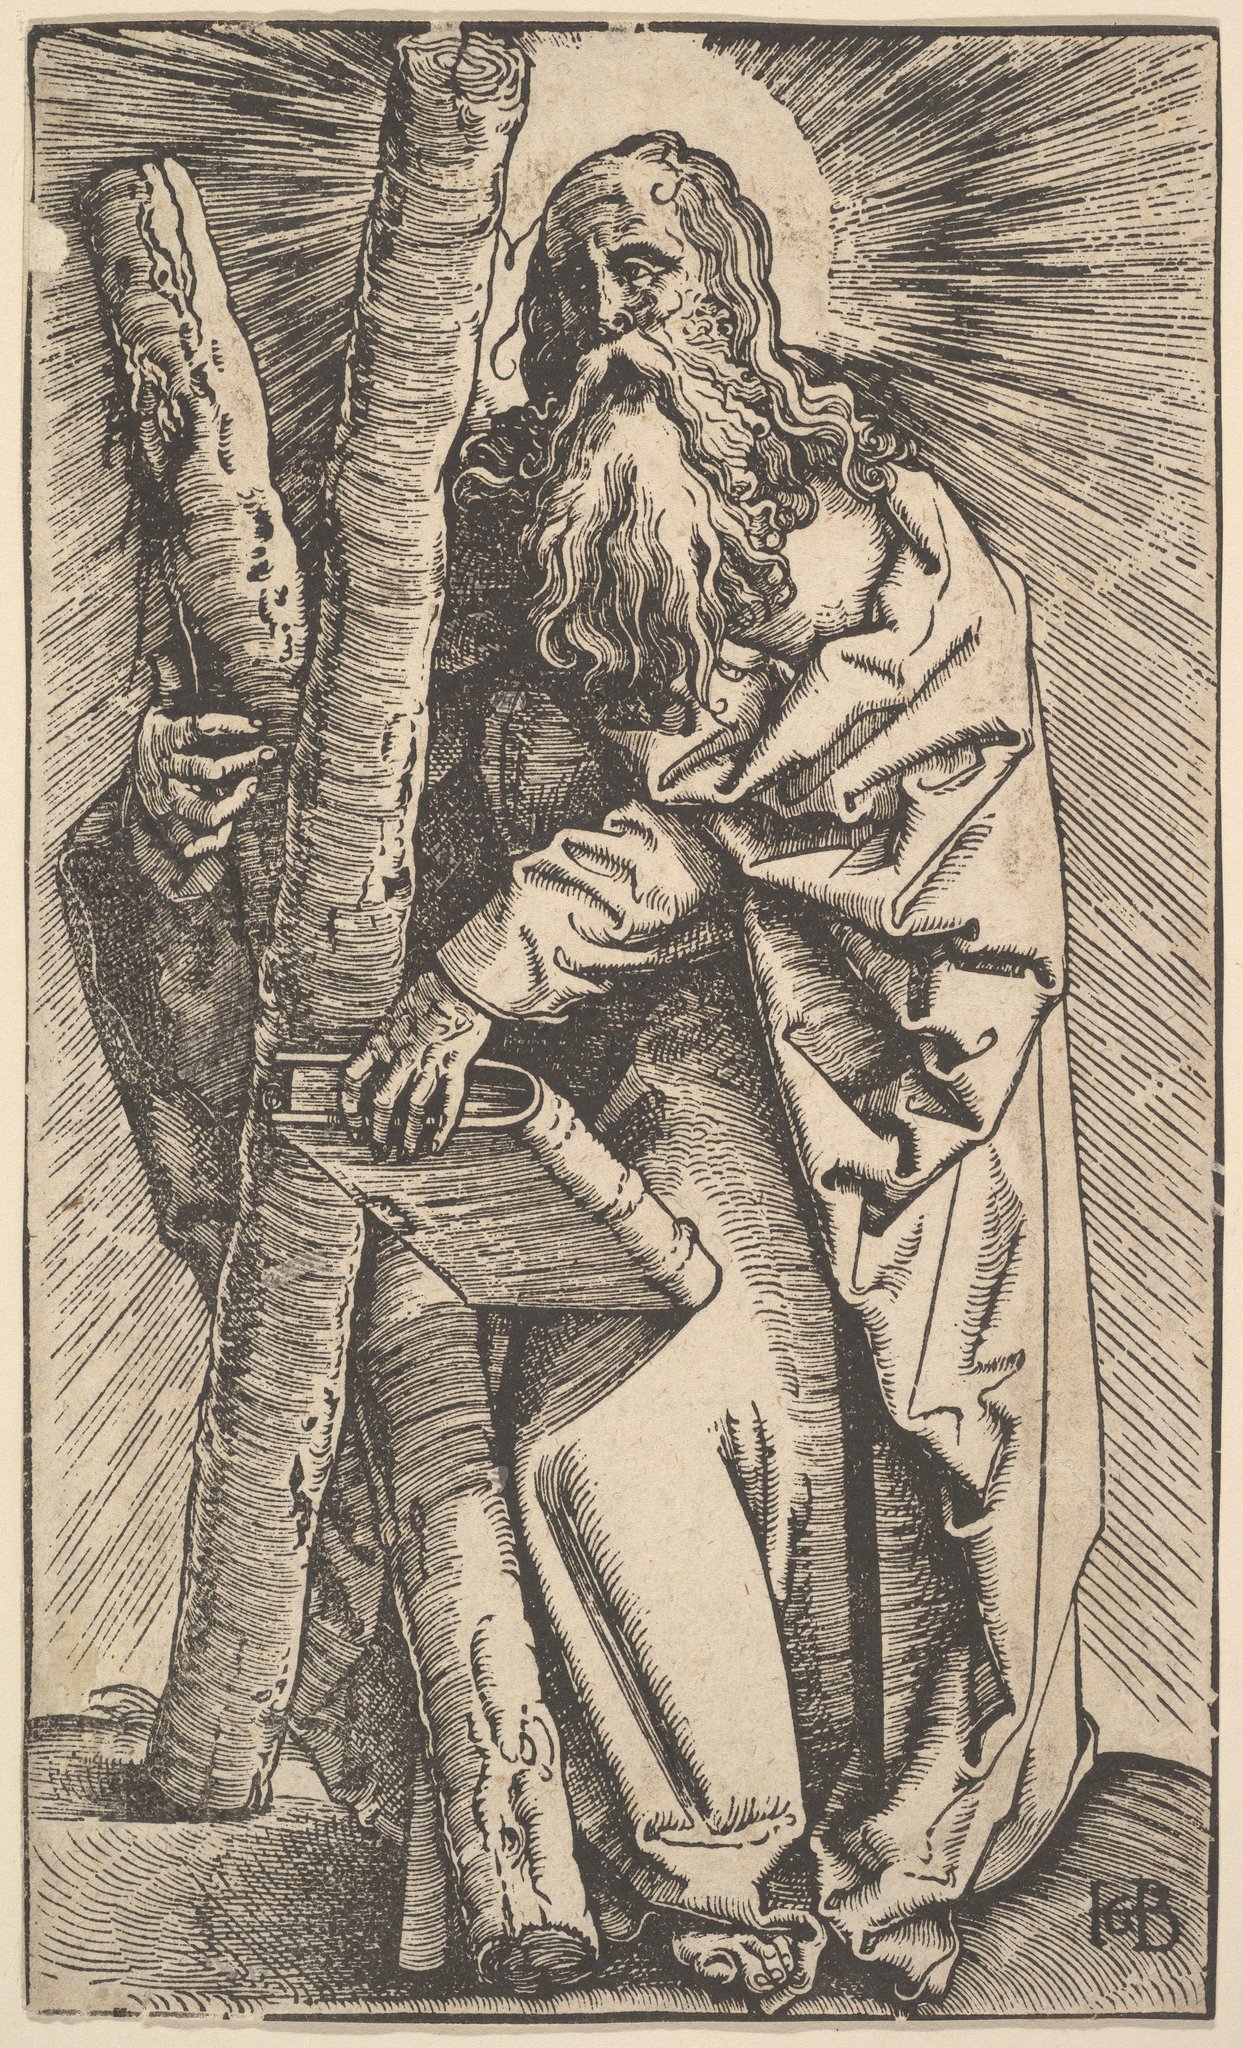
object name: print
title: St. Andrew, from "Christ and the Apostles"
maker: hans baldung (called hans baldung grien)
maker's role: artist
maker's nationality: german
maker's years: 1484-1545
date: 1519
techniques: woodcut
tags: books,saints